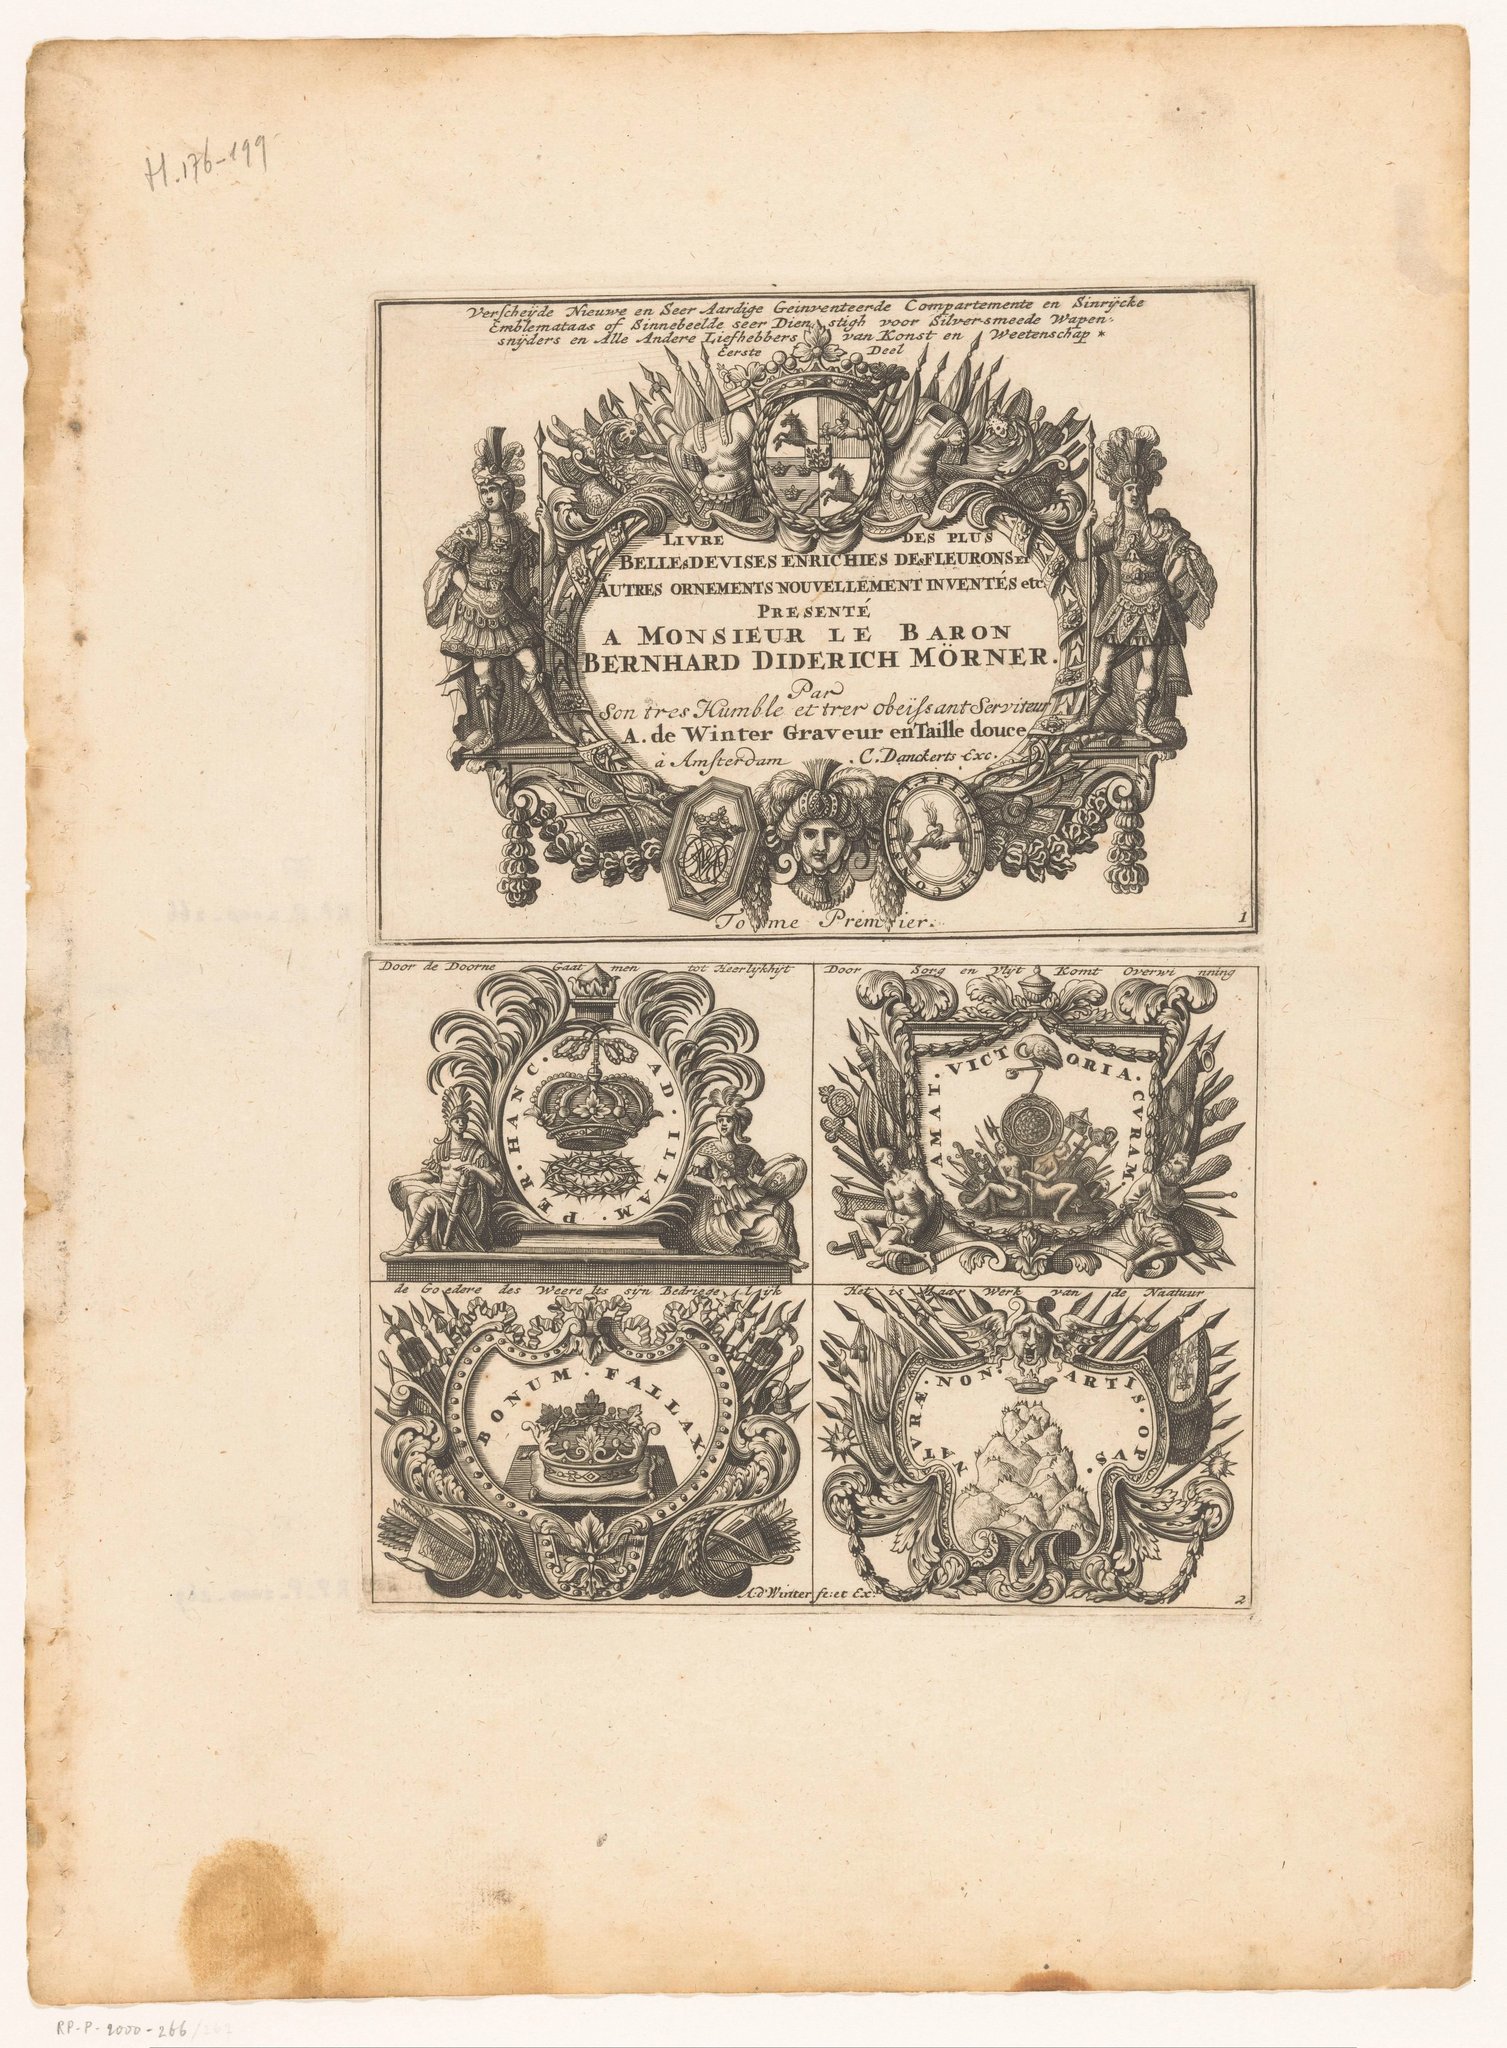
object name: print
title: Cartouche en emblemata met kronen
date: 1697-1718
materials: paper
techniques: engraving, etching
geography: amsterdam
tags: crown (symbol of sovereignty), ornament ~ cartouche, abstract ideas and concepts (+ emblematical representation of concept)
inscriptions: collector's mark: Lugt 2760, collector's mark: Lugt 2228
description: Een cartouche en vier emblemata met Nederlandse tekst en Latijns motto op een blad. Boven: Cartouche met serietitel omgeven door wapens, vlaggen en schilden. Aan de bovenzijde een gekroond wapenschild. Geflankeerd door twee figuren in harnas. Onder: Emblemata met een kroon boven een doornenkroon, een ooievaar op een schild omgeven door wapens en twee zittende figuren, een kroon op een kussen en een kroon boven een berg.